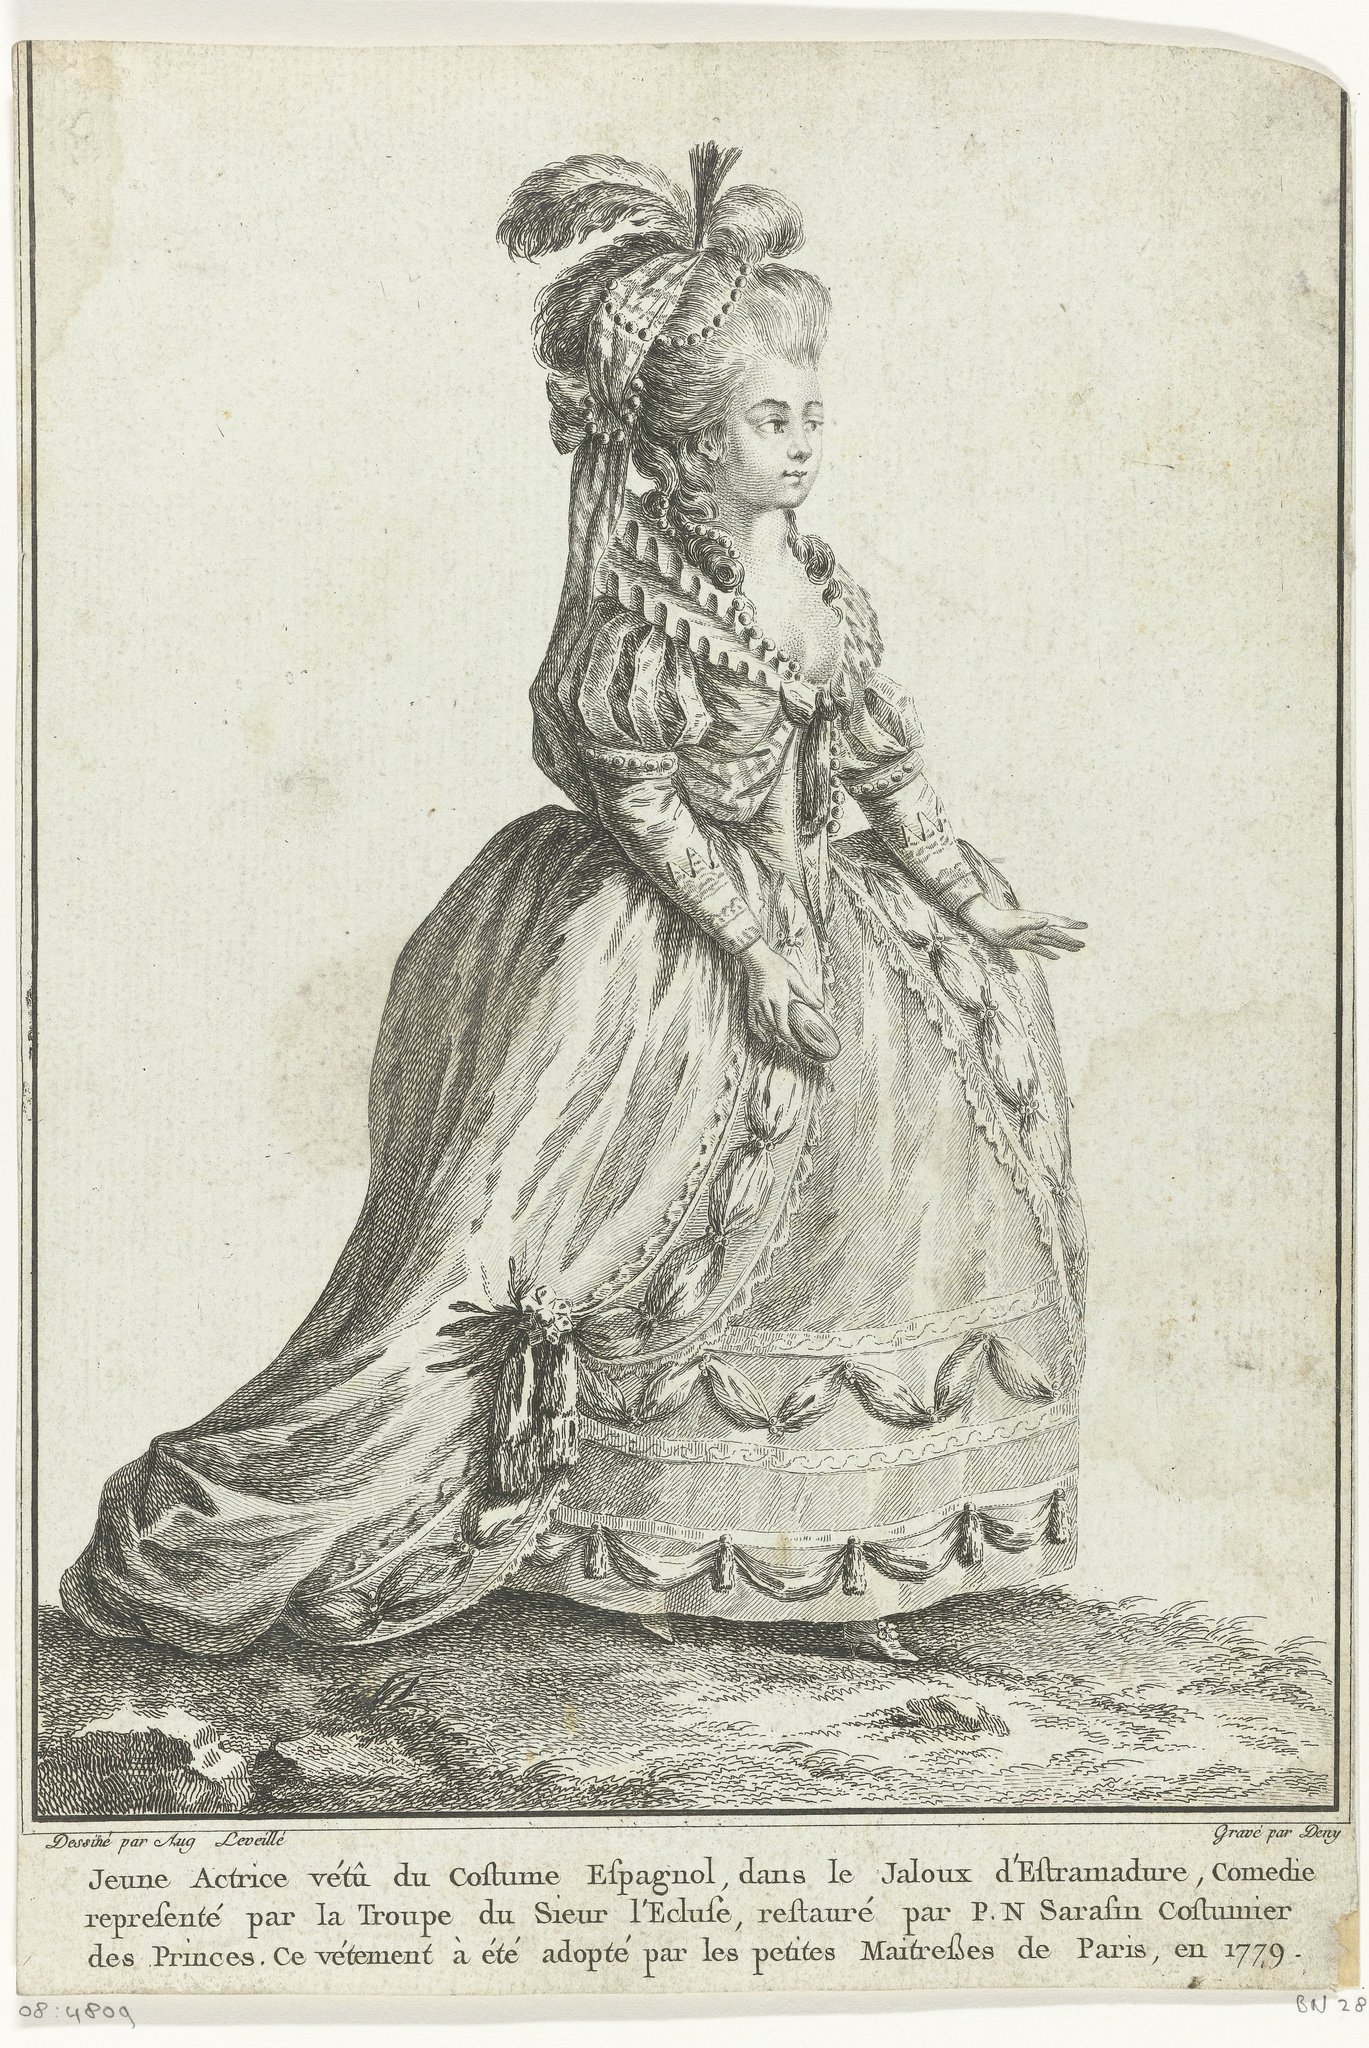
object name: costume print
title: Jeune Actrice, vêtu du Costume Espagnol (...)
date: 1779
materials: paper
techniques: engraving, etching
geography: paris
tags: border, ribbon, braid (+ women's clothes), styles of hairdress - aa - ~ women, fashion plates, dress, gown (+ women's clothes), stage costume - cc - female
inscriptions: caption: ‘Jeune Actrice, vetu du costume Espagnol, dans le Jaloux d'Estramadure, Comedie representé par la Troupe du Sieur l'Ecluse, restauré par P.N. Sarasin Costumier des Princes. Ce vètement a été adopté par les petites Maitresses de Paris, en 1799.’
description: Een jonge actrice, gekleed in een Spaans kostuum in het toneelstuk 'Le Jaloux d'Estramadure', een komedie uitgevoerd door de Troupe van de heer l'Ecluse (Troupe de l'Opera Comique). De kostuums zijn ontworpen door Monsieur P.N. Sarasin, hofkleermaker van de koninklijke familie. Zij kwamen later (1799) in de mode bij de 'petites Maitresses' van Parijs. No. C.16 uit de serie Collection d'Habillements modernes et galants, avec les habillements des princes et seigneurs, 1779.